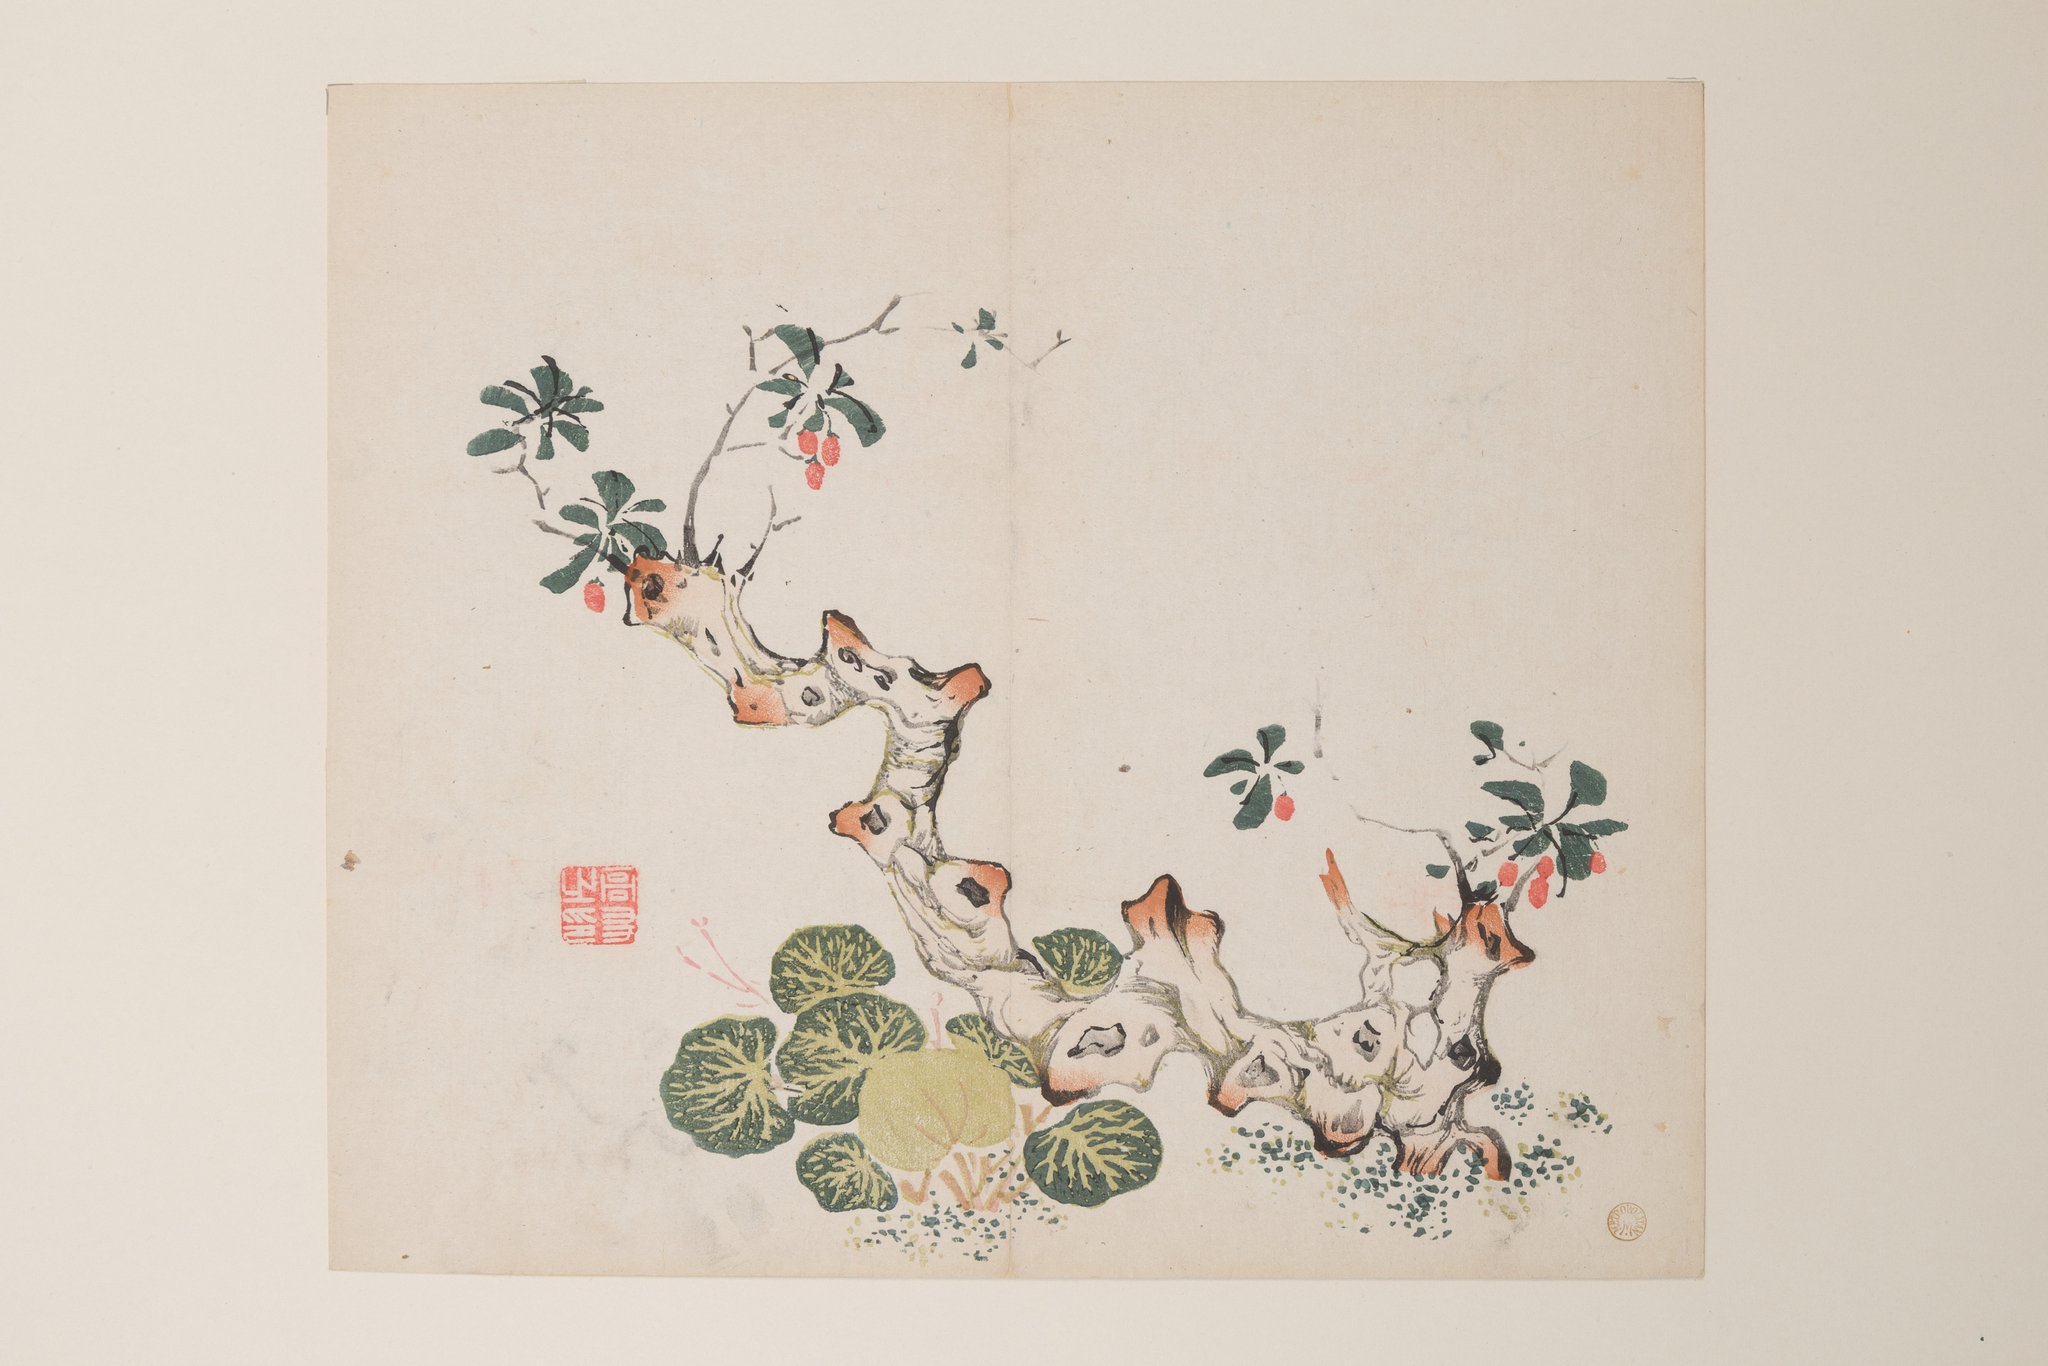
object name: print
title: Leaf from the Ten Bamboo Studio Manual of Painting and Calligraphy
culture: chinese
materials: ink, paper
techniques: printing